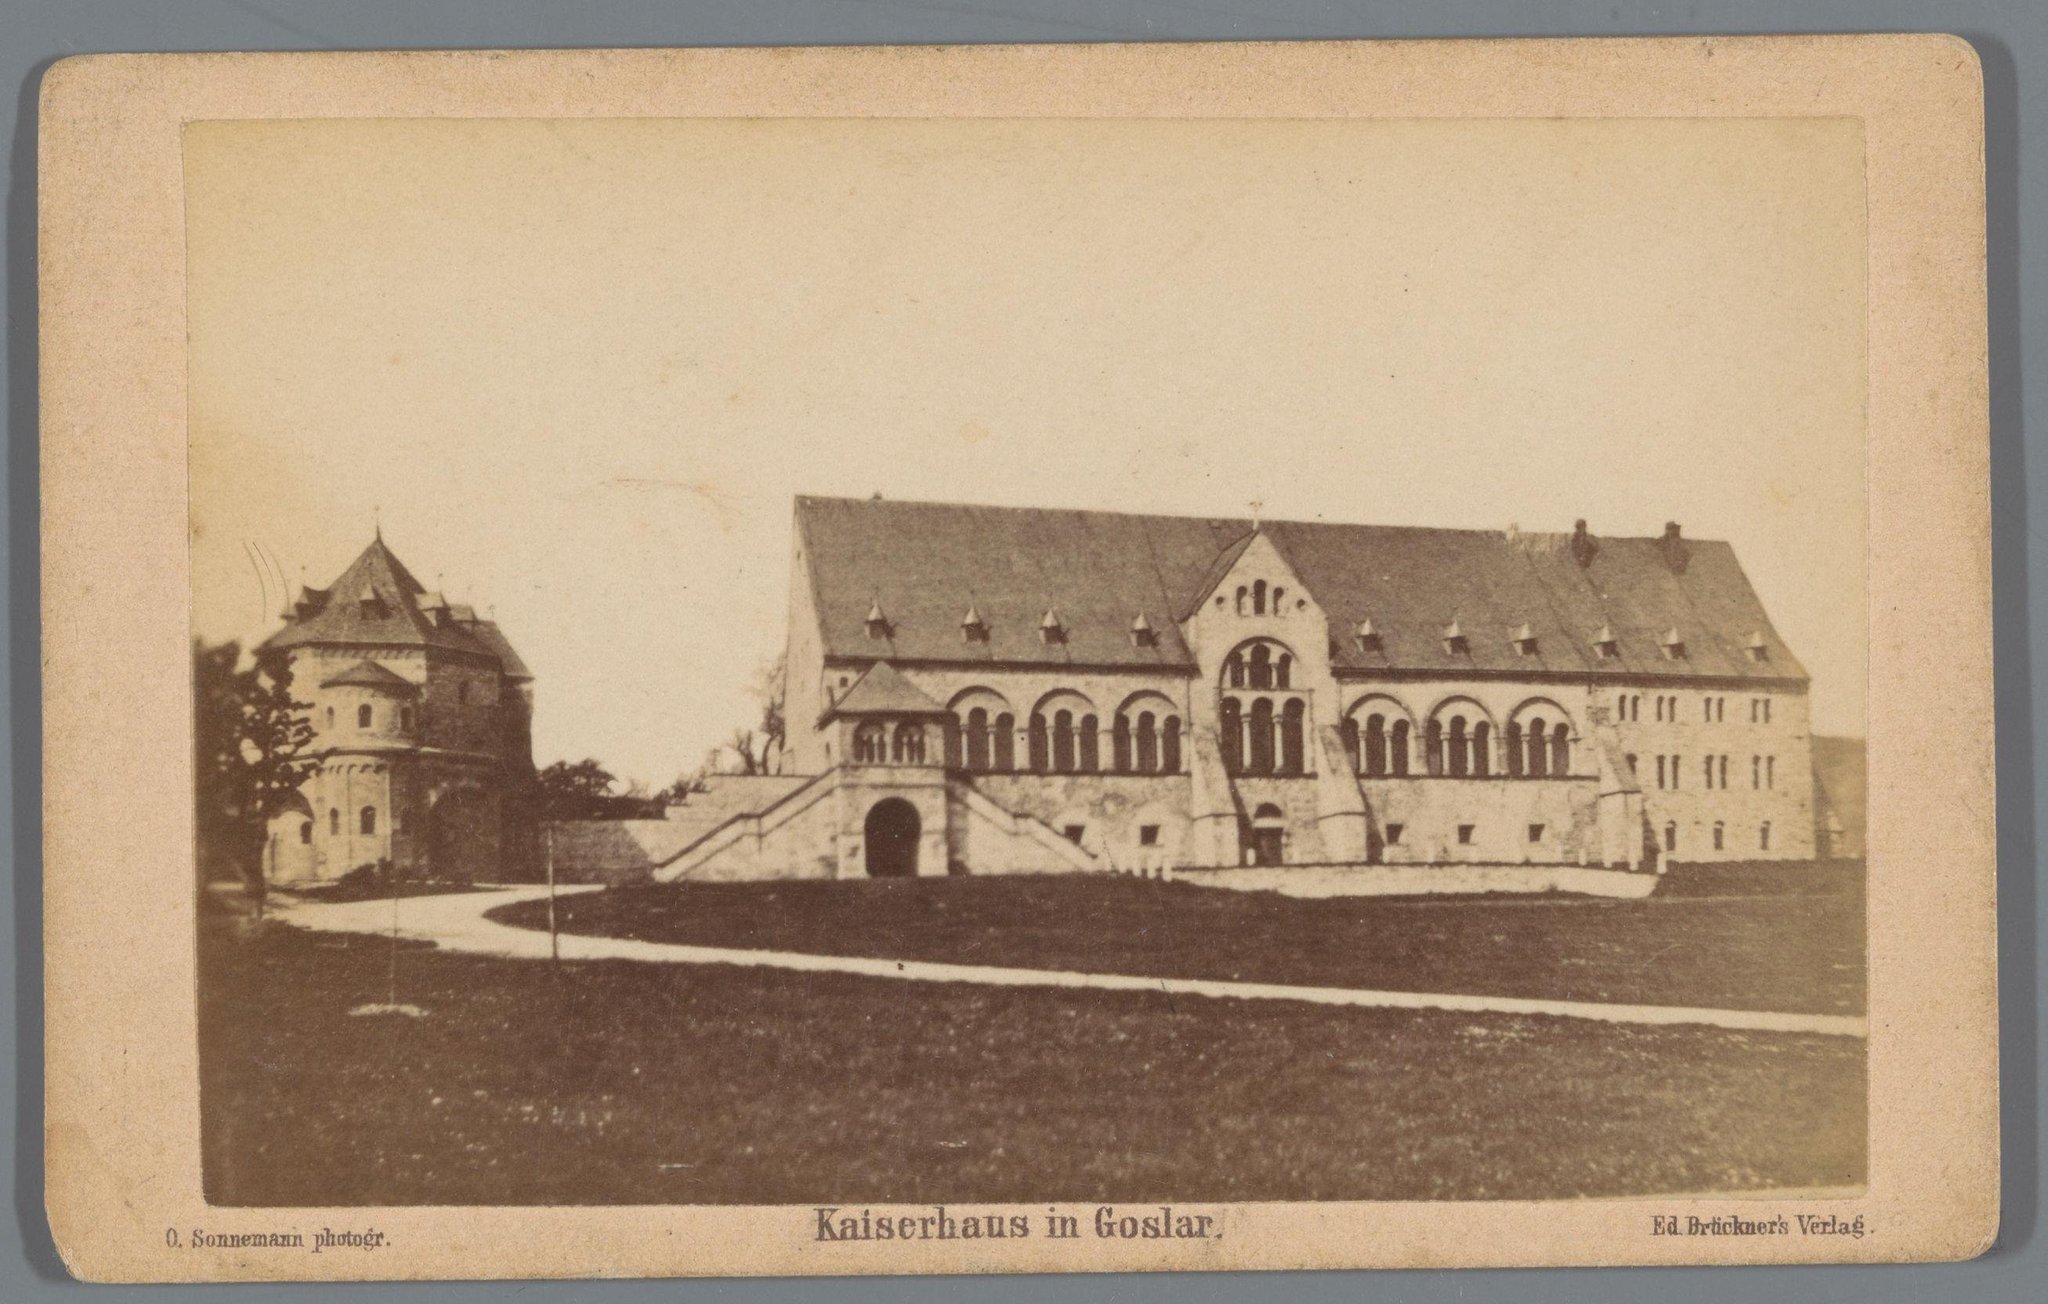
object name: photograph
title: Kaiserhaus in Goslar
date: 1860-1875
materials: cardboard, paper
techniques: albumen print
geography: goslar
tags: exterior ~ representation of a building